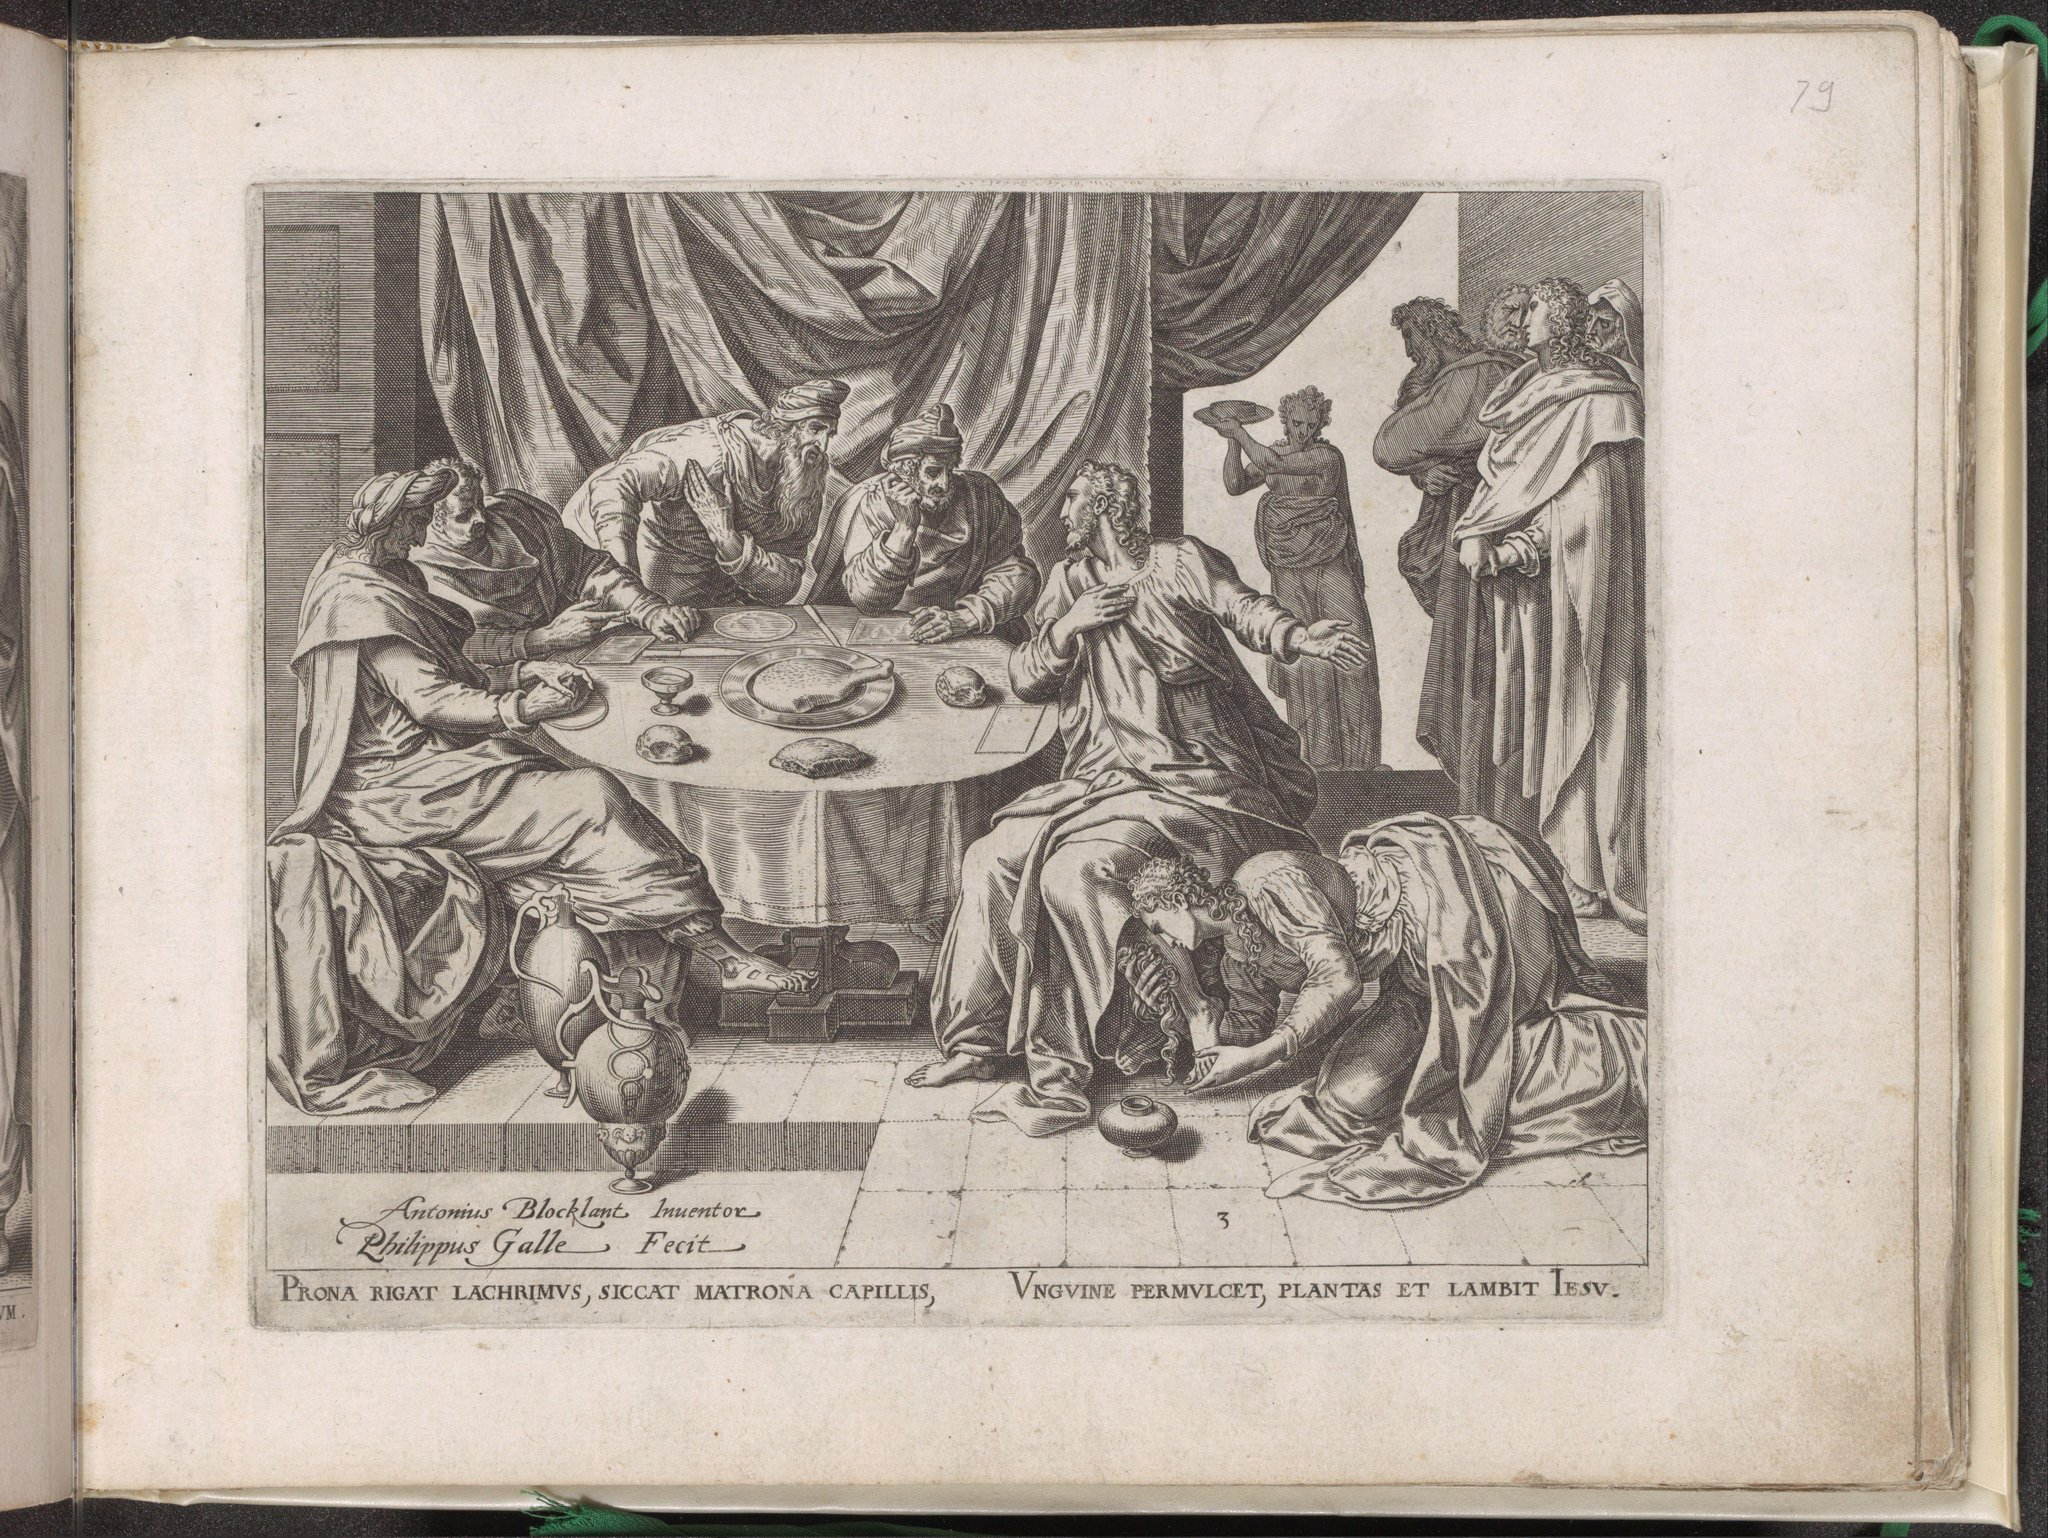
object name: album leaf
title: Christus gezalfd door Maria Magdalena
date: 1575-1581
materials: paper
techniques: engraving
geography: antwerp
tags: christ's feet are anointed by mary (magdalene)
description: Christus zit aan tafel te eten in het huis van Simon de Farizeeër. Maria Magdalena knielt op de grond naast hem, zalft zijn voeten met olie en droogt ze met haar haren. Onder de voorstelling een verwijzing in het Latijn naar de Bijbeltekst. Deze prent maakt deel uit van een album.